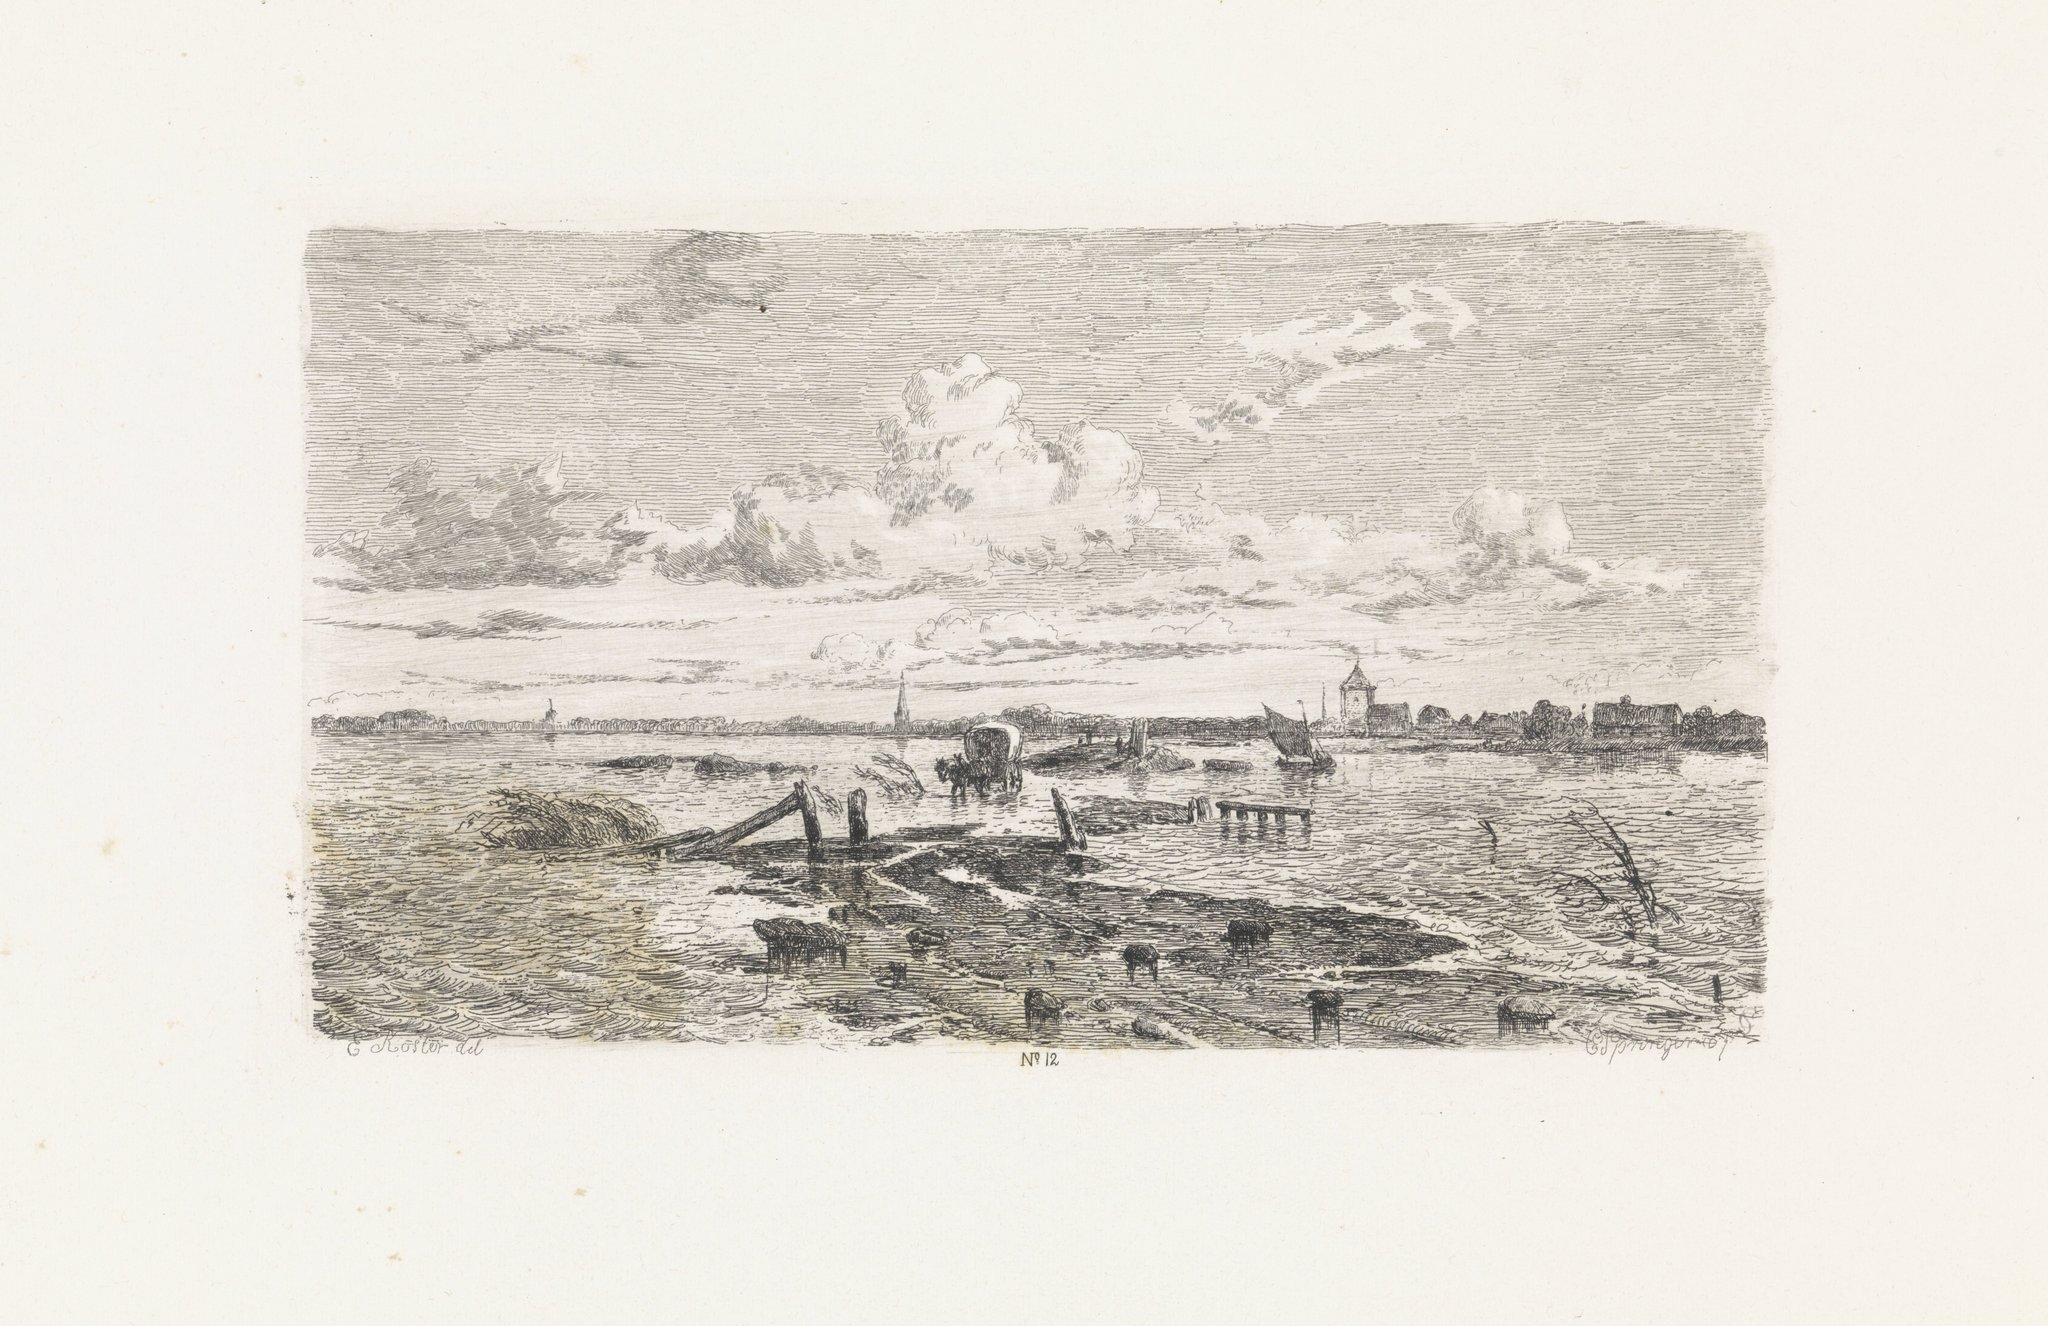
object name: print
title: Overstroomd landschap tussen Oss en Lith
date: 1855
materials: paper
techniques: etching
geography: amsterdam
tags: flood, oss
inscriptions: collector's mark: Lugt 2228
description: Nummer 12 uit de serie: "De waterramp van 1855 geschetst in 24 afbeeldingen, naar de natuur geteekend en geëtst door leden der Maatschappij Arti et Amicitiae". De uitgave had tot doel de slachtoffers van deze watersnoodramp te helpen.